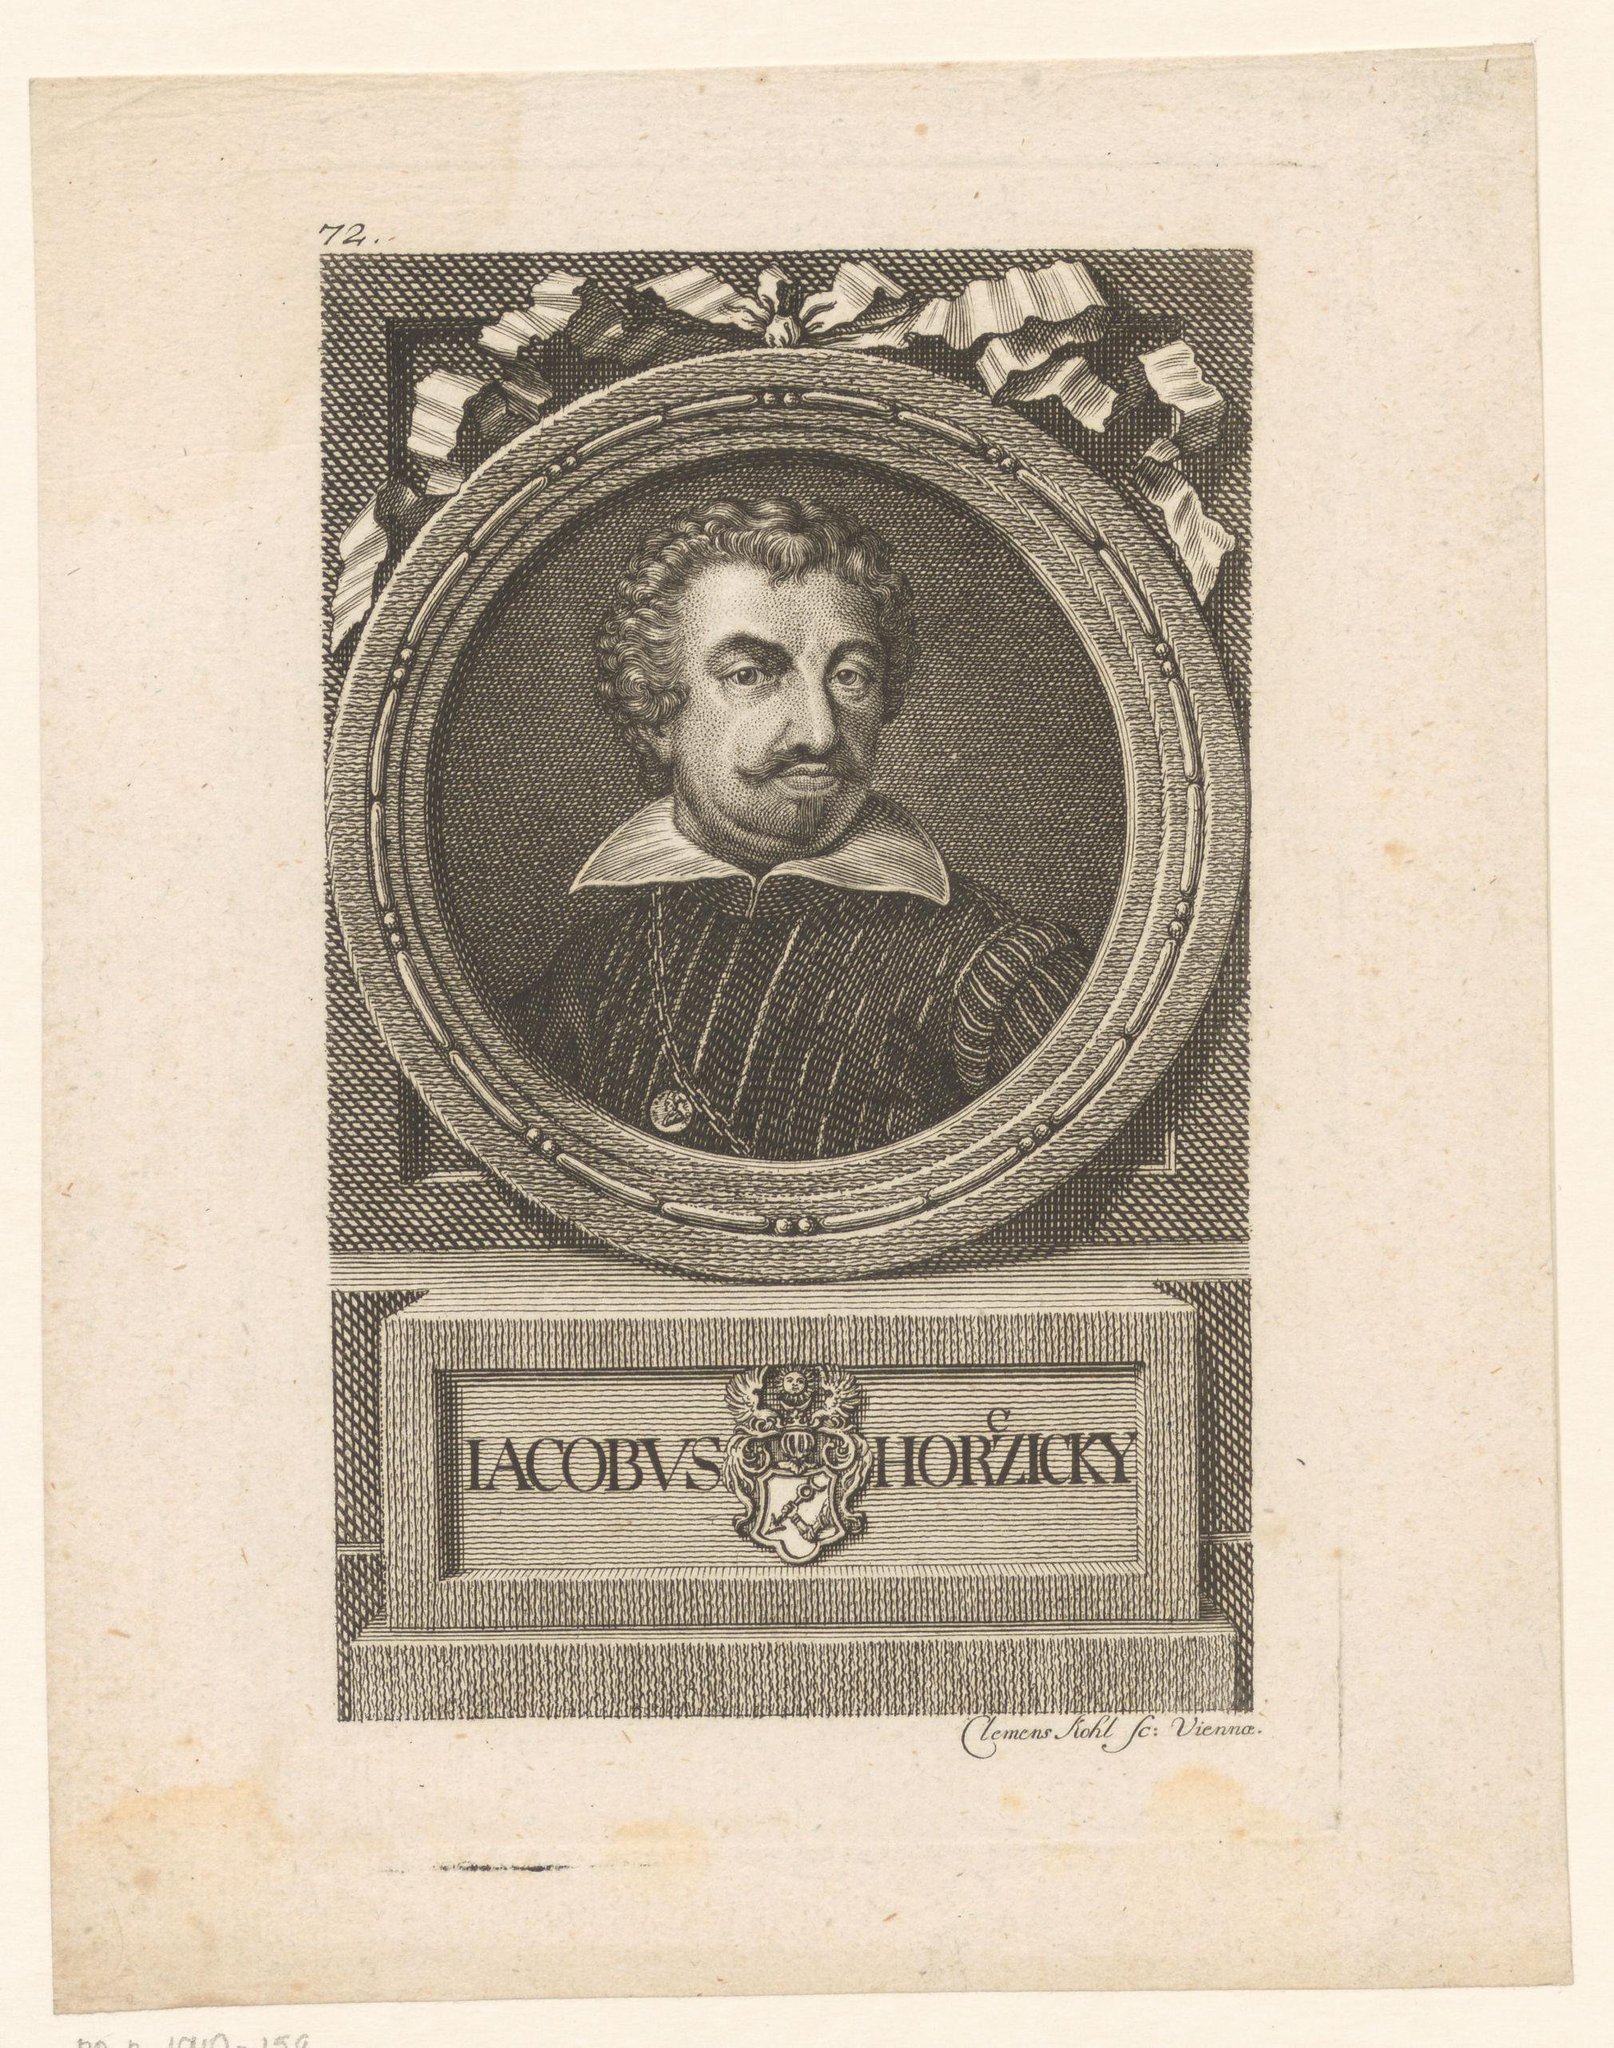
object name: print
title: Portret van Jacobus Horczicky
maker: clemens kohl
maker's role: draughtsman, print maker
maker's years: 1754-1807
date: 1764-1807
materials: paper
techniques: engraving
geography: vienna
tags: pharmacist, druggist, apothecary; pharmacy, drugstore, dispensing chemist (+ portrait of scholar, scientist), historical persons, physician, doctor (+ portrait of scholar, scientist)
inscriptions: number: ‘72.’, collector's mark: Lugt 2228